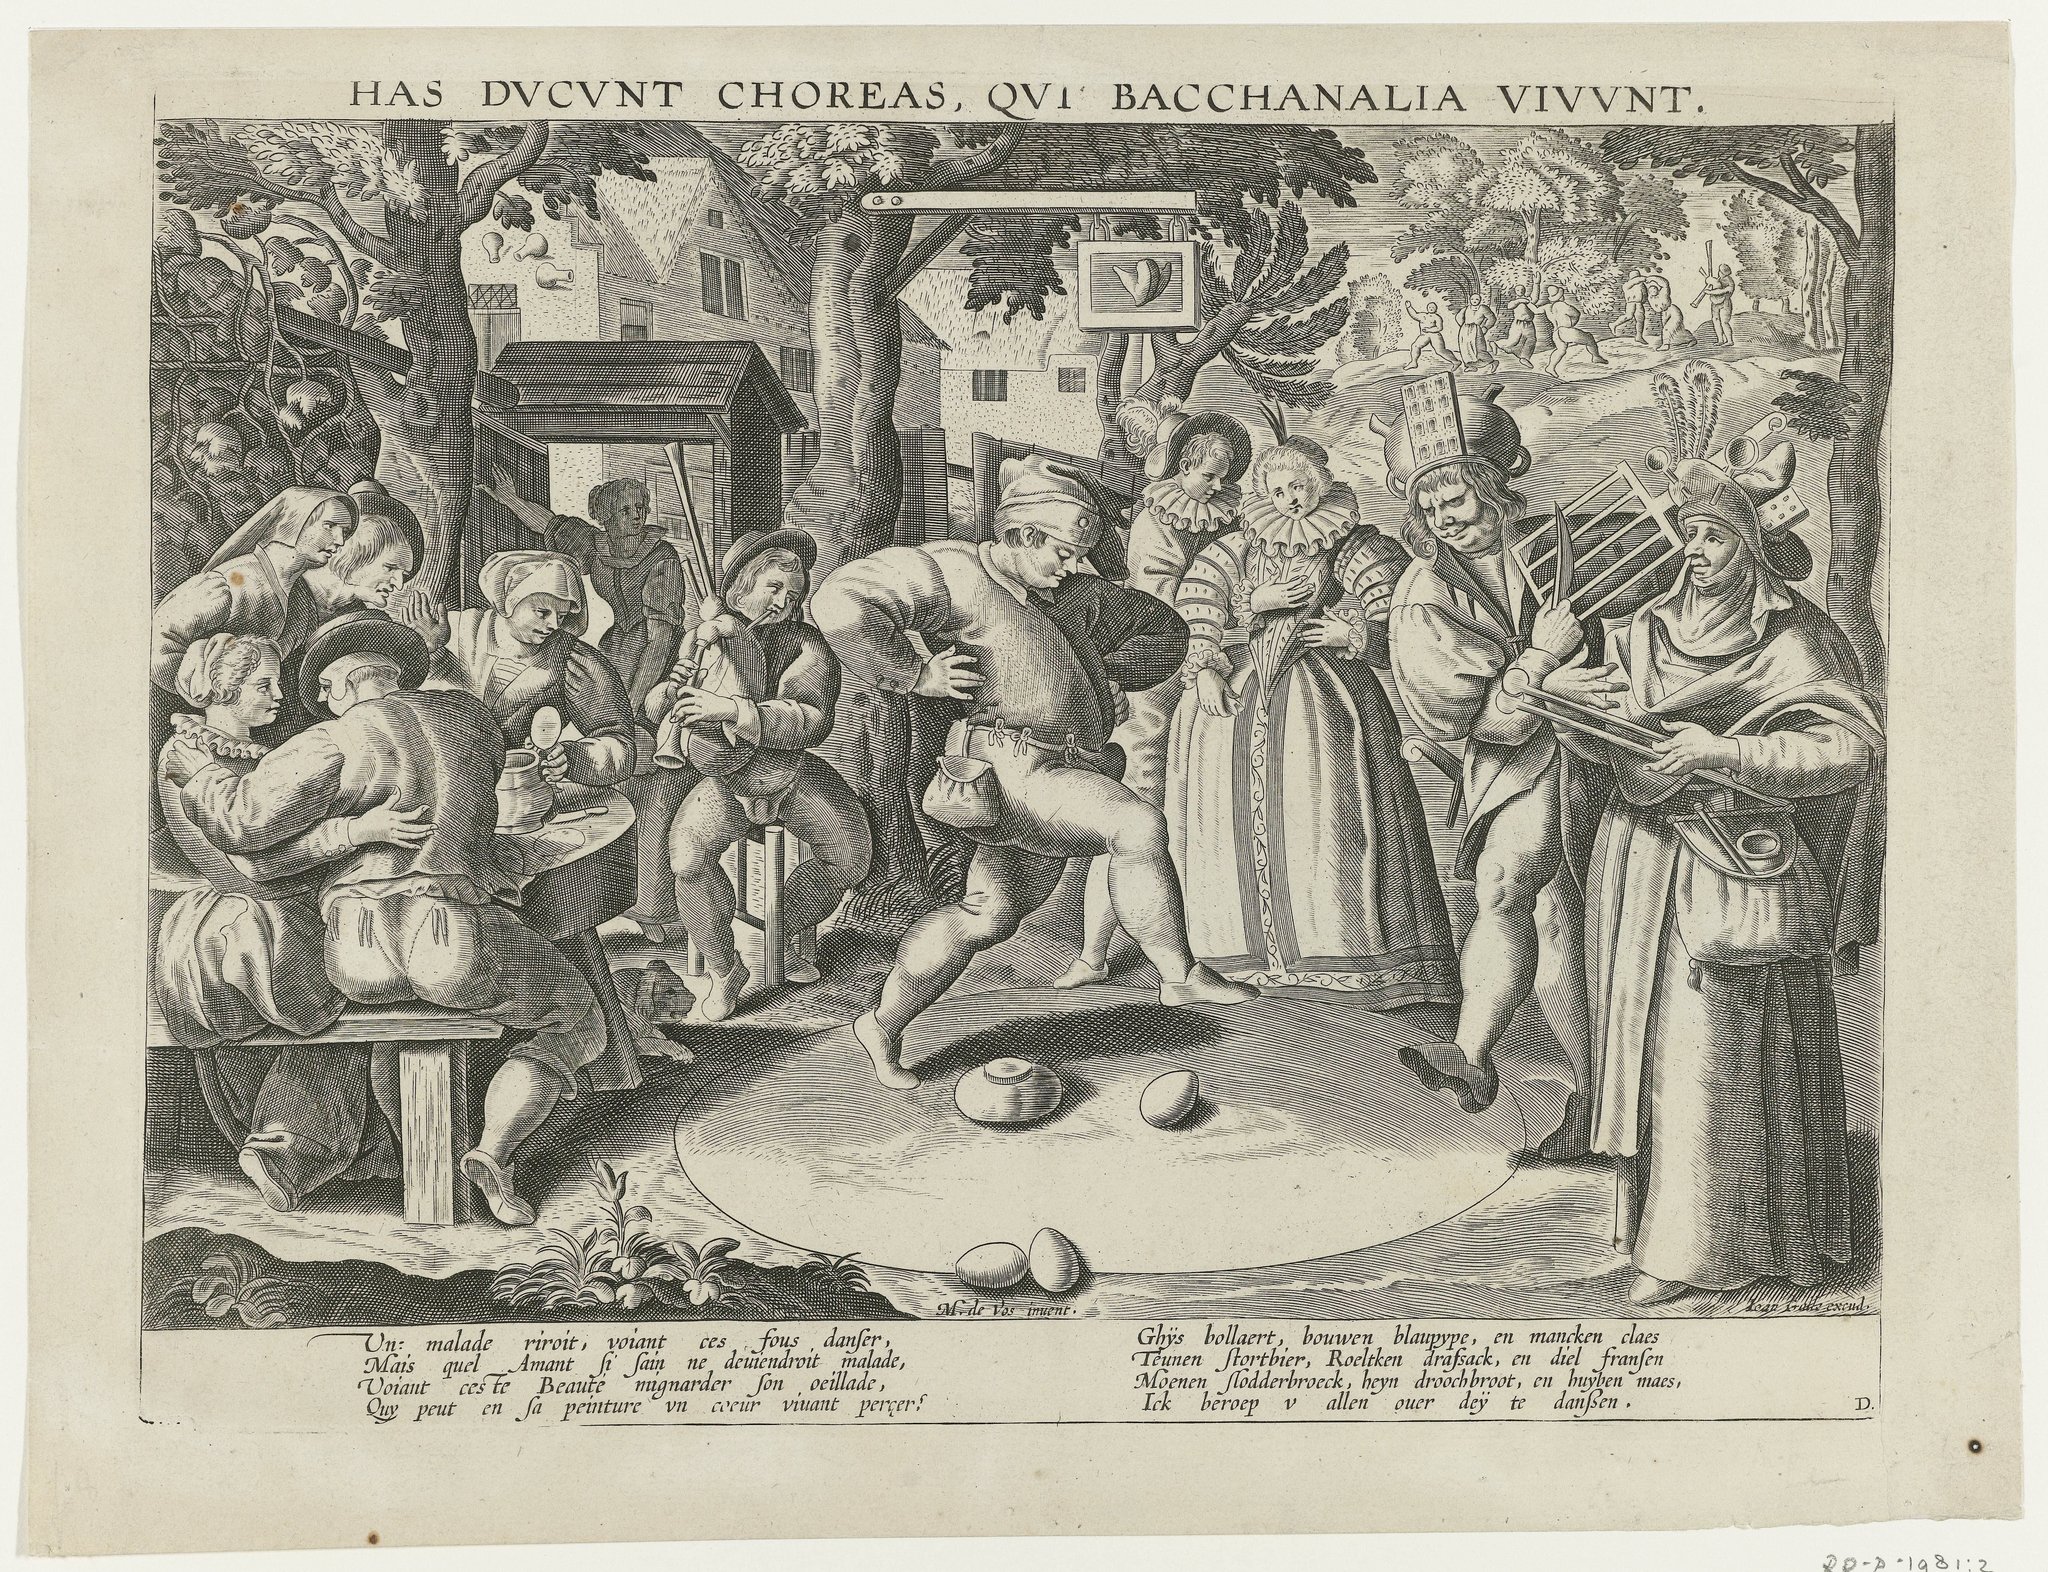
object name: print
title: Eierdans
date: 1626-1676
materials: paper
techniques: engraving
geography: antwerp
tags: making music; musician with instrument - cc - out of doors, group dancing around someone or something (folk dancing), festivities (+ games of skill ~ festive activities), drinking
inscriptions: collector's mark: Lugt 2760, collector's mark: Lugt 2228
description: Een jonge man danst op de muziek van twee charivarimuzikanten en een doedelzakspeler in een cirkel om een ei heen. Boven zijn hoofd een uithangbord met daarop het middendeel van een mannenbroek, een verwijzing naar het erotische karakter van de eierdans. Links een drinkend gezelschap dat toekijkt. Achter de dansende man wordt een vrouw omhelsd door een man. Op de achtergrond een dansende groep en een doedelzakspeler. Boven een éénregelige tekst in het Latijn. Onder in de marge een vierregelig onderschrift in het Frans en Nederlands. Rechtsonder: D.